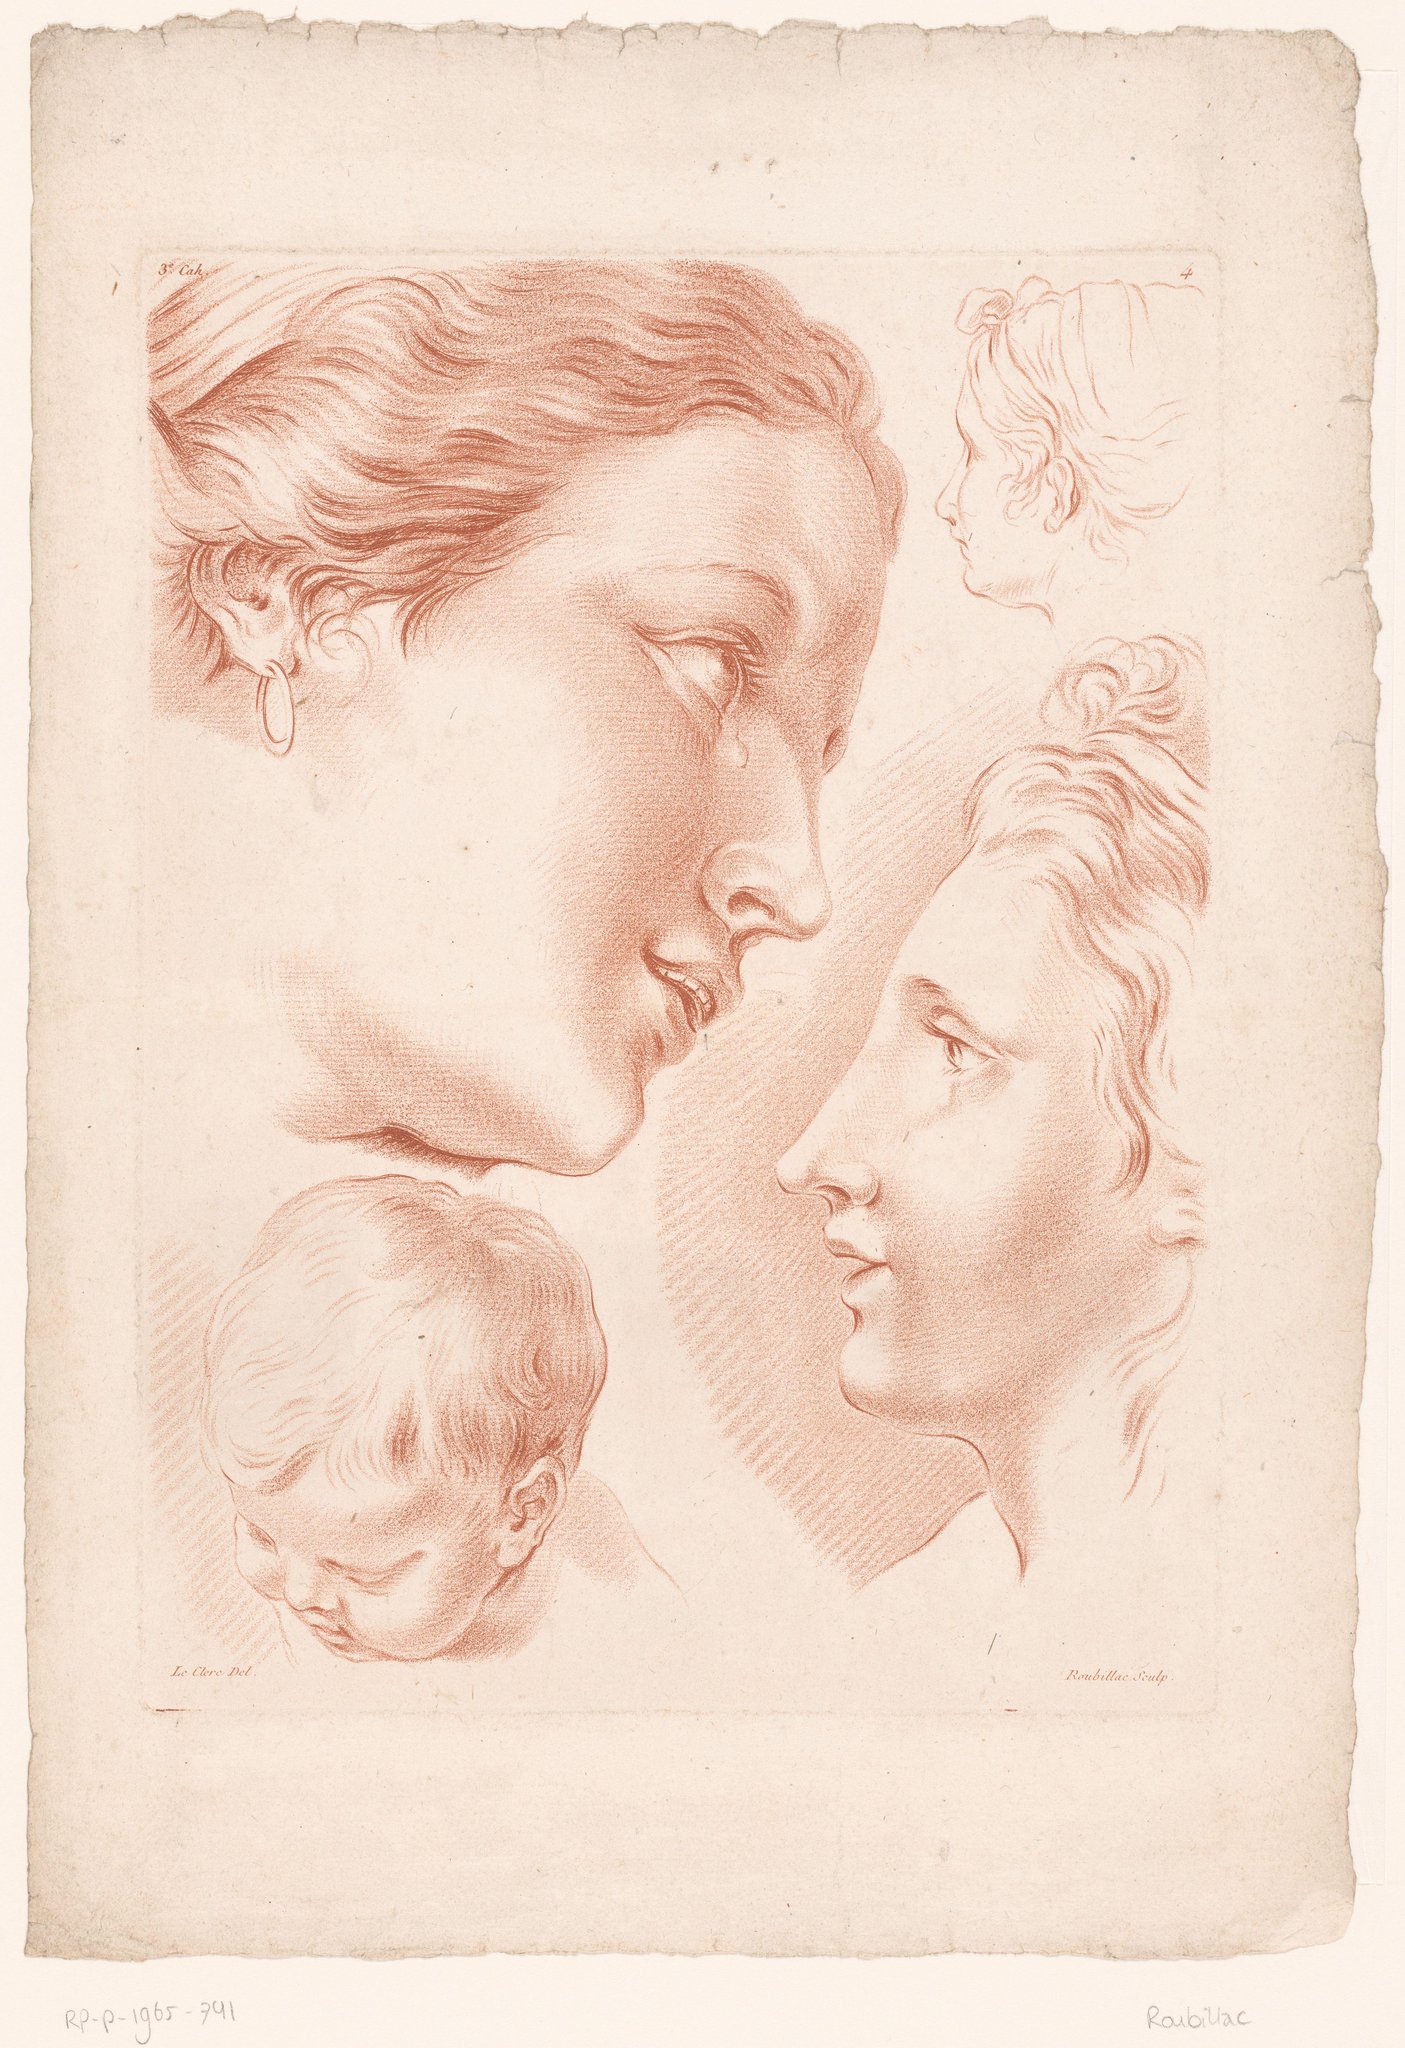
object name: print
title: Principes van het tekenen naar de natuur, deel drie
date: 1784-1796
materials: paper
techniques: printmaking, etching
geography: paris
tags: drawing, sketch, child, head (human) - aa - female human figure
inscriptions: collector's mark: Lugt 2228